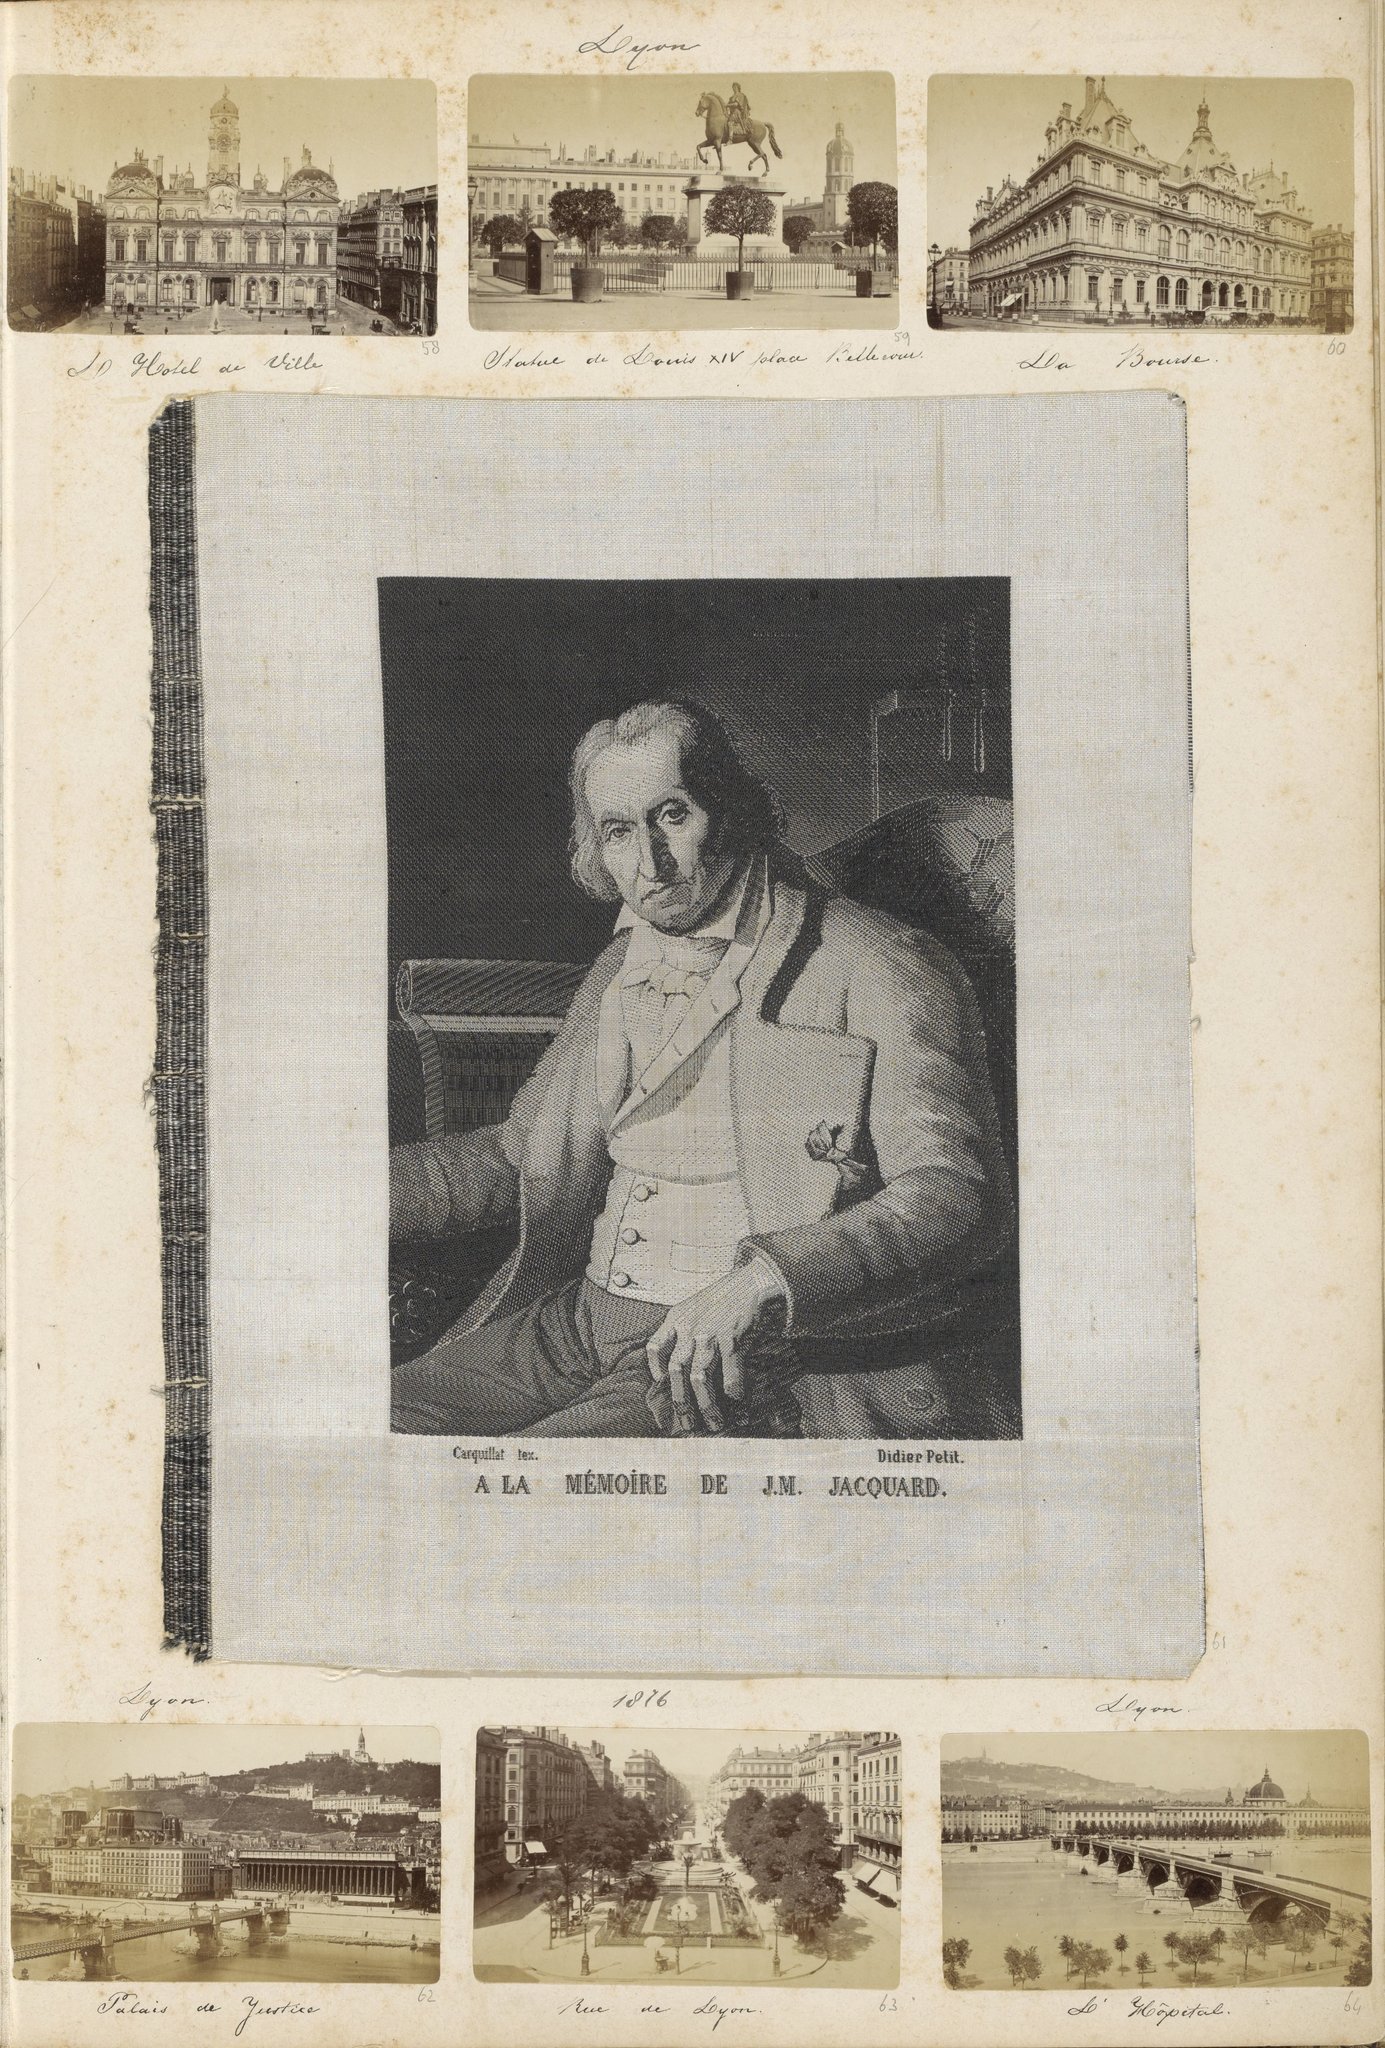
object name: album leaf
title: Exterieur van het beursgebouw van Lyon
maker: Anonymous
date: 1870-1880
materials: paper, photographic support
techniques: albumen print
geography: lyon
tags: exchange, bourse, lyon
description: Onderdeel van Fotoalbum van Robert Daniel Crommelin (1841-1907).